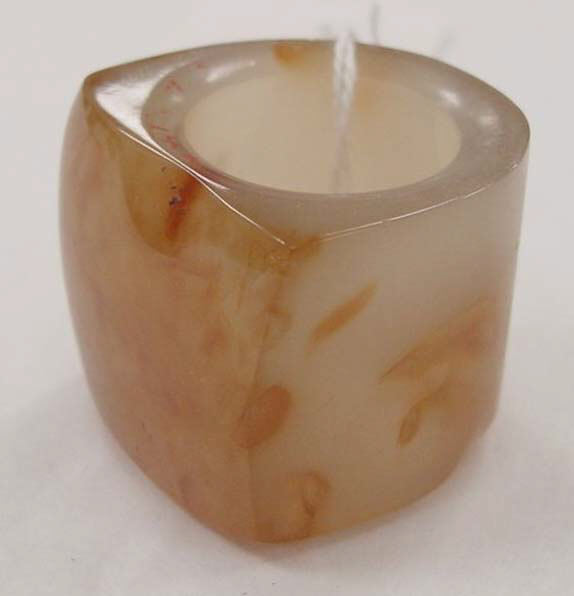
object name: ring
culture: chinese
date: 1801-1900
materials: jade